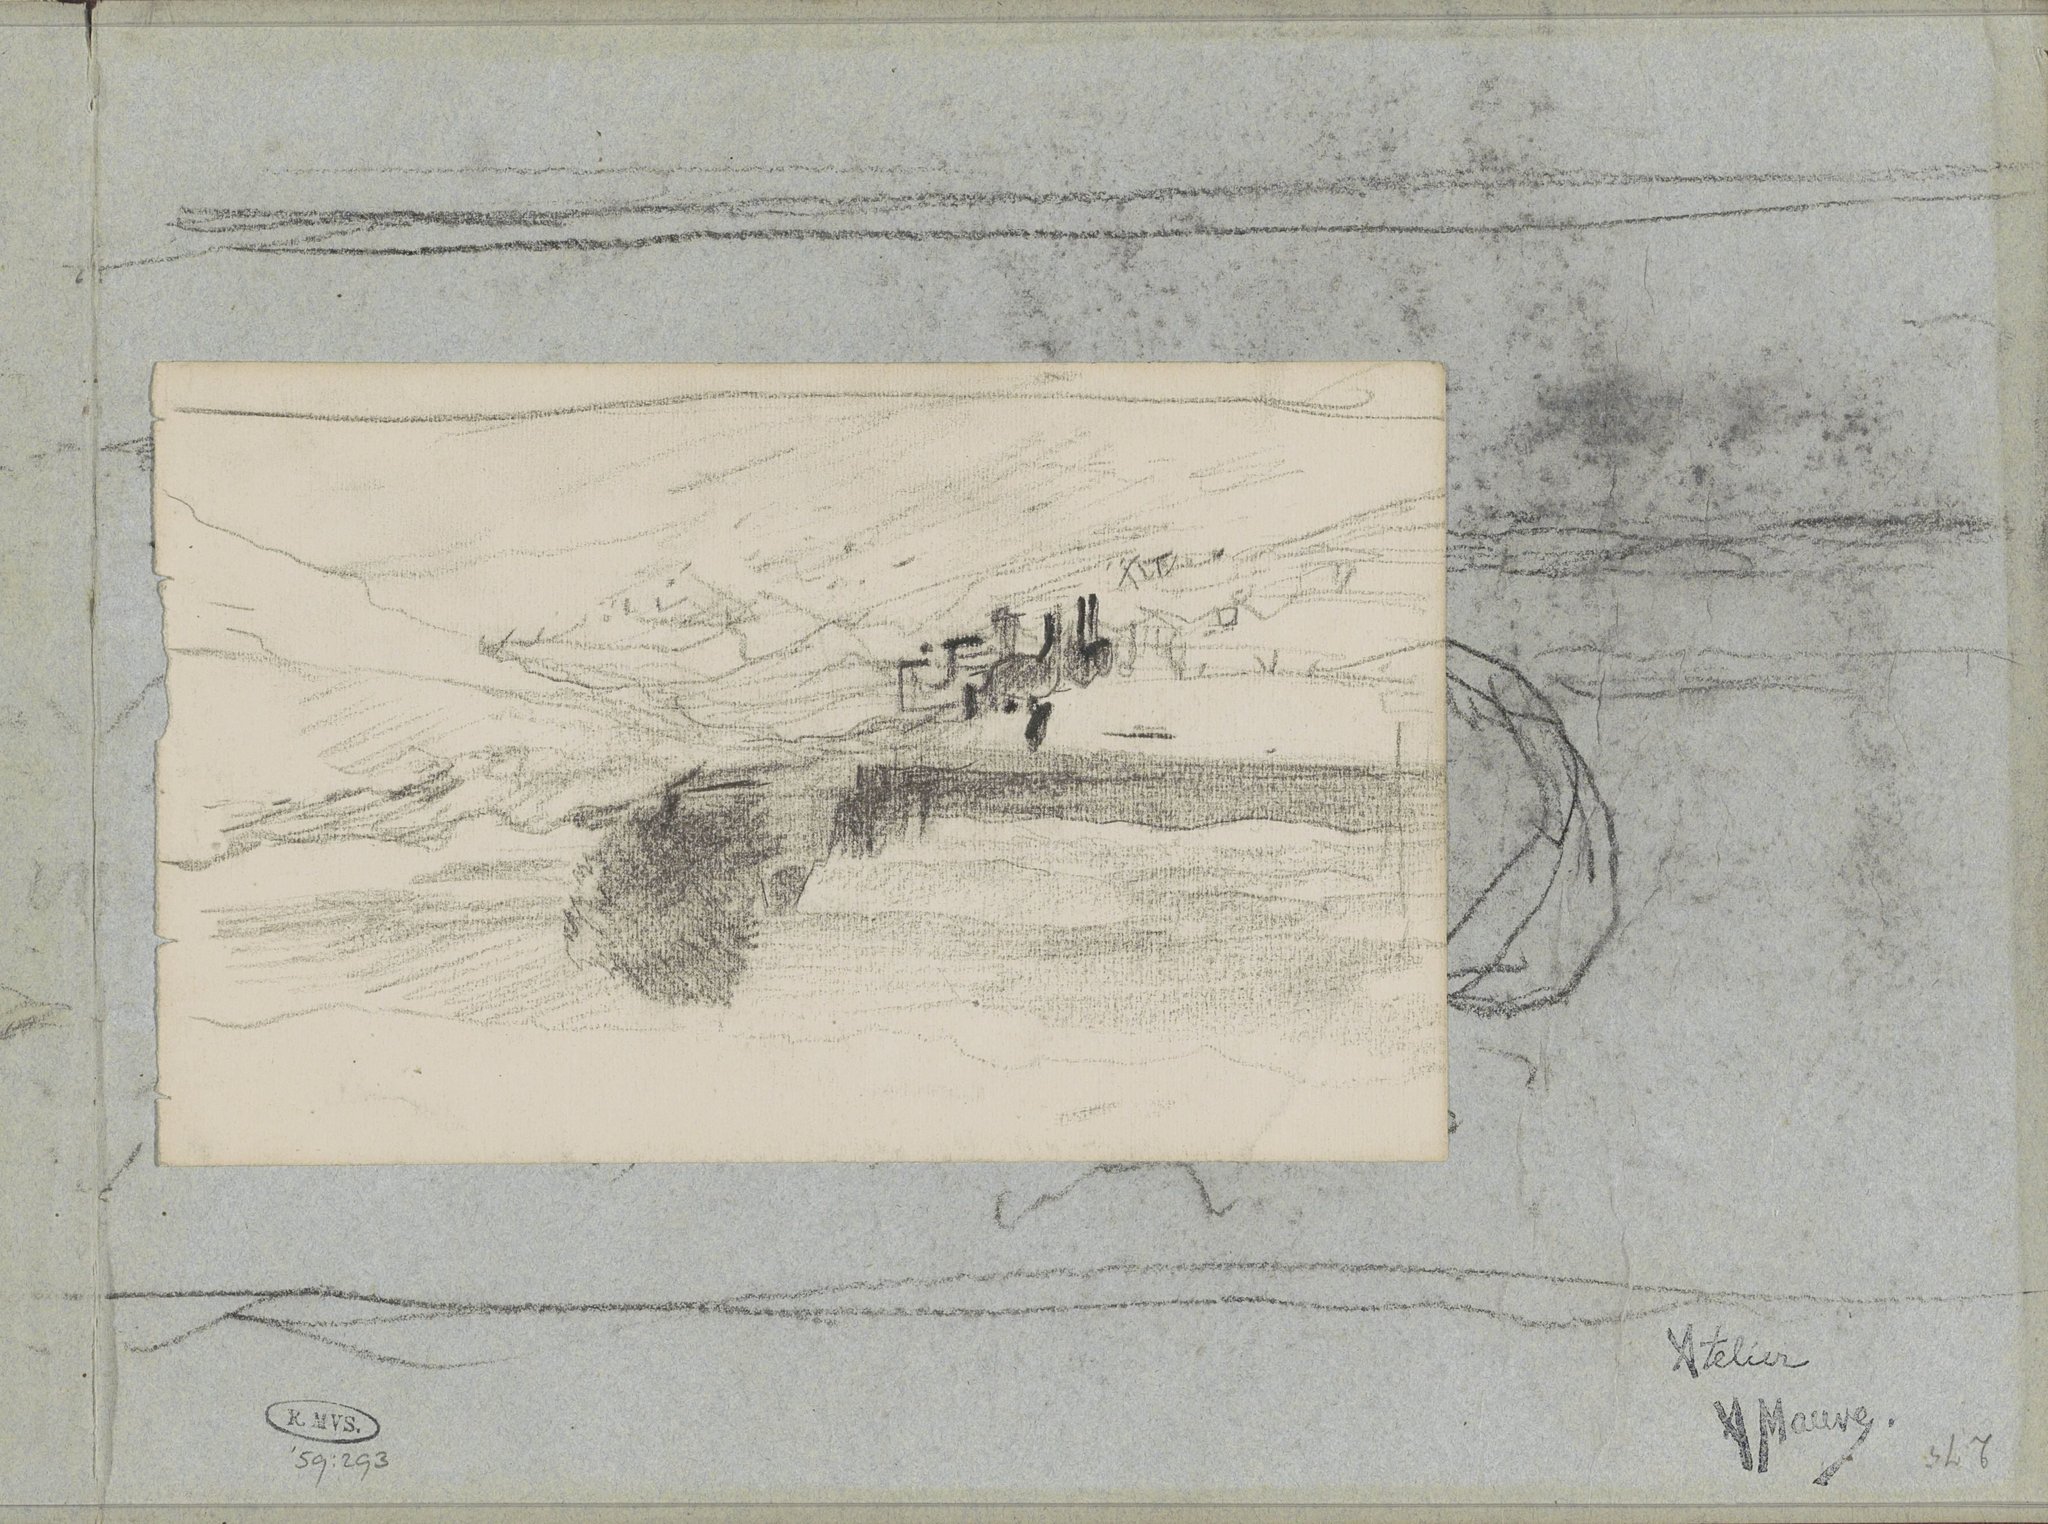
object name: sketchbook leaf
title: Paarden bij een aanlegplaats aan een waterkant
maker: anton mauve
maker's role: draughtsman, painter, print maker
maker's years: 1838-1888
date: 1886-1888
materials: chalk, paper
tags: landscapes with waters, waterscapes, seascapes (in the temperate zone), dikes, levee, horse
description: De paarden staan bij een dijk. Op de achtergrond bebouwing. Recto-zijde van een los blad tussen pagina 27 en het achterste schutblad uit een schetsboek met 27 bladen.